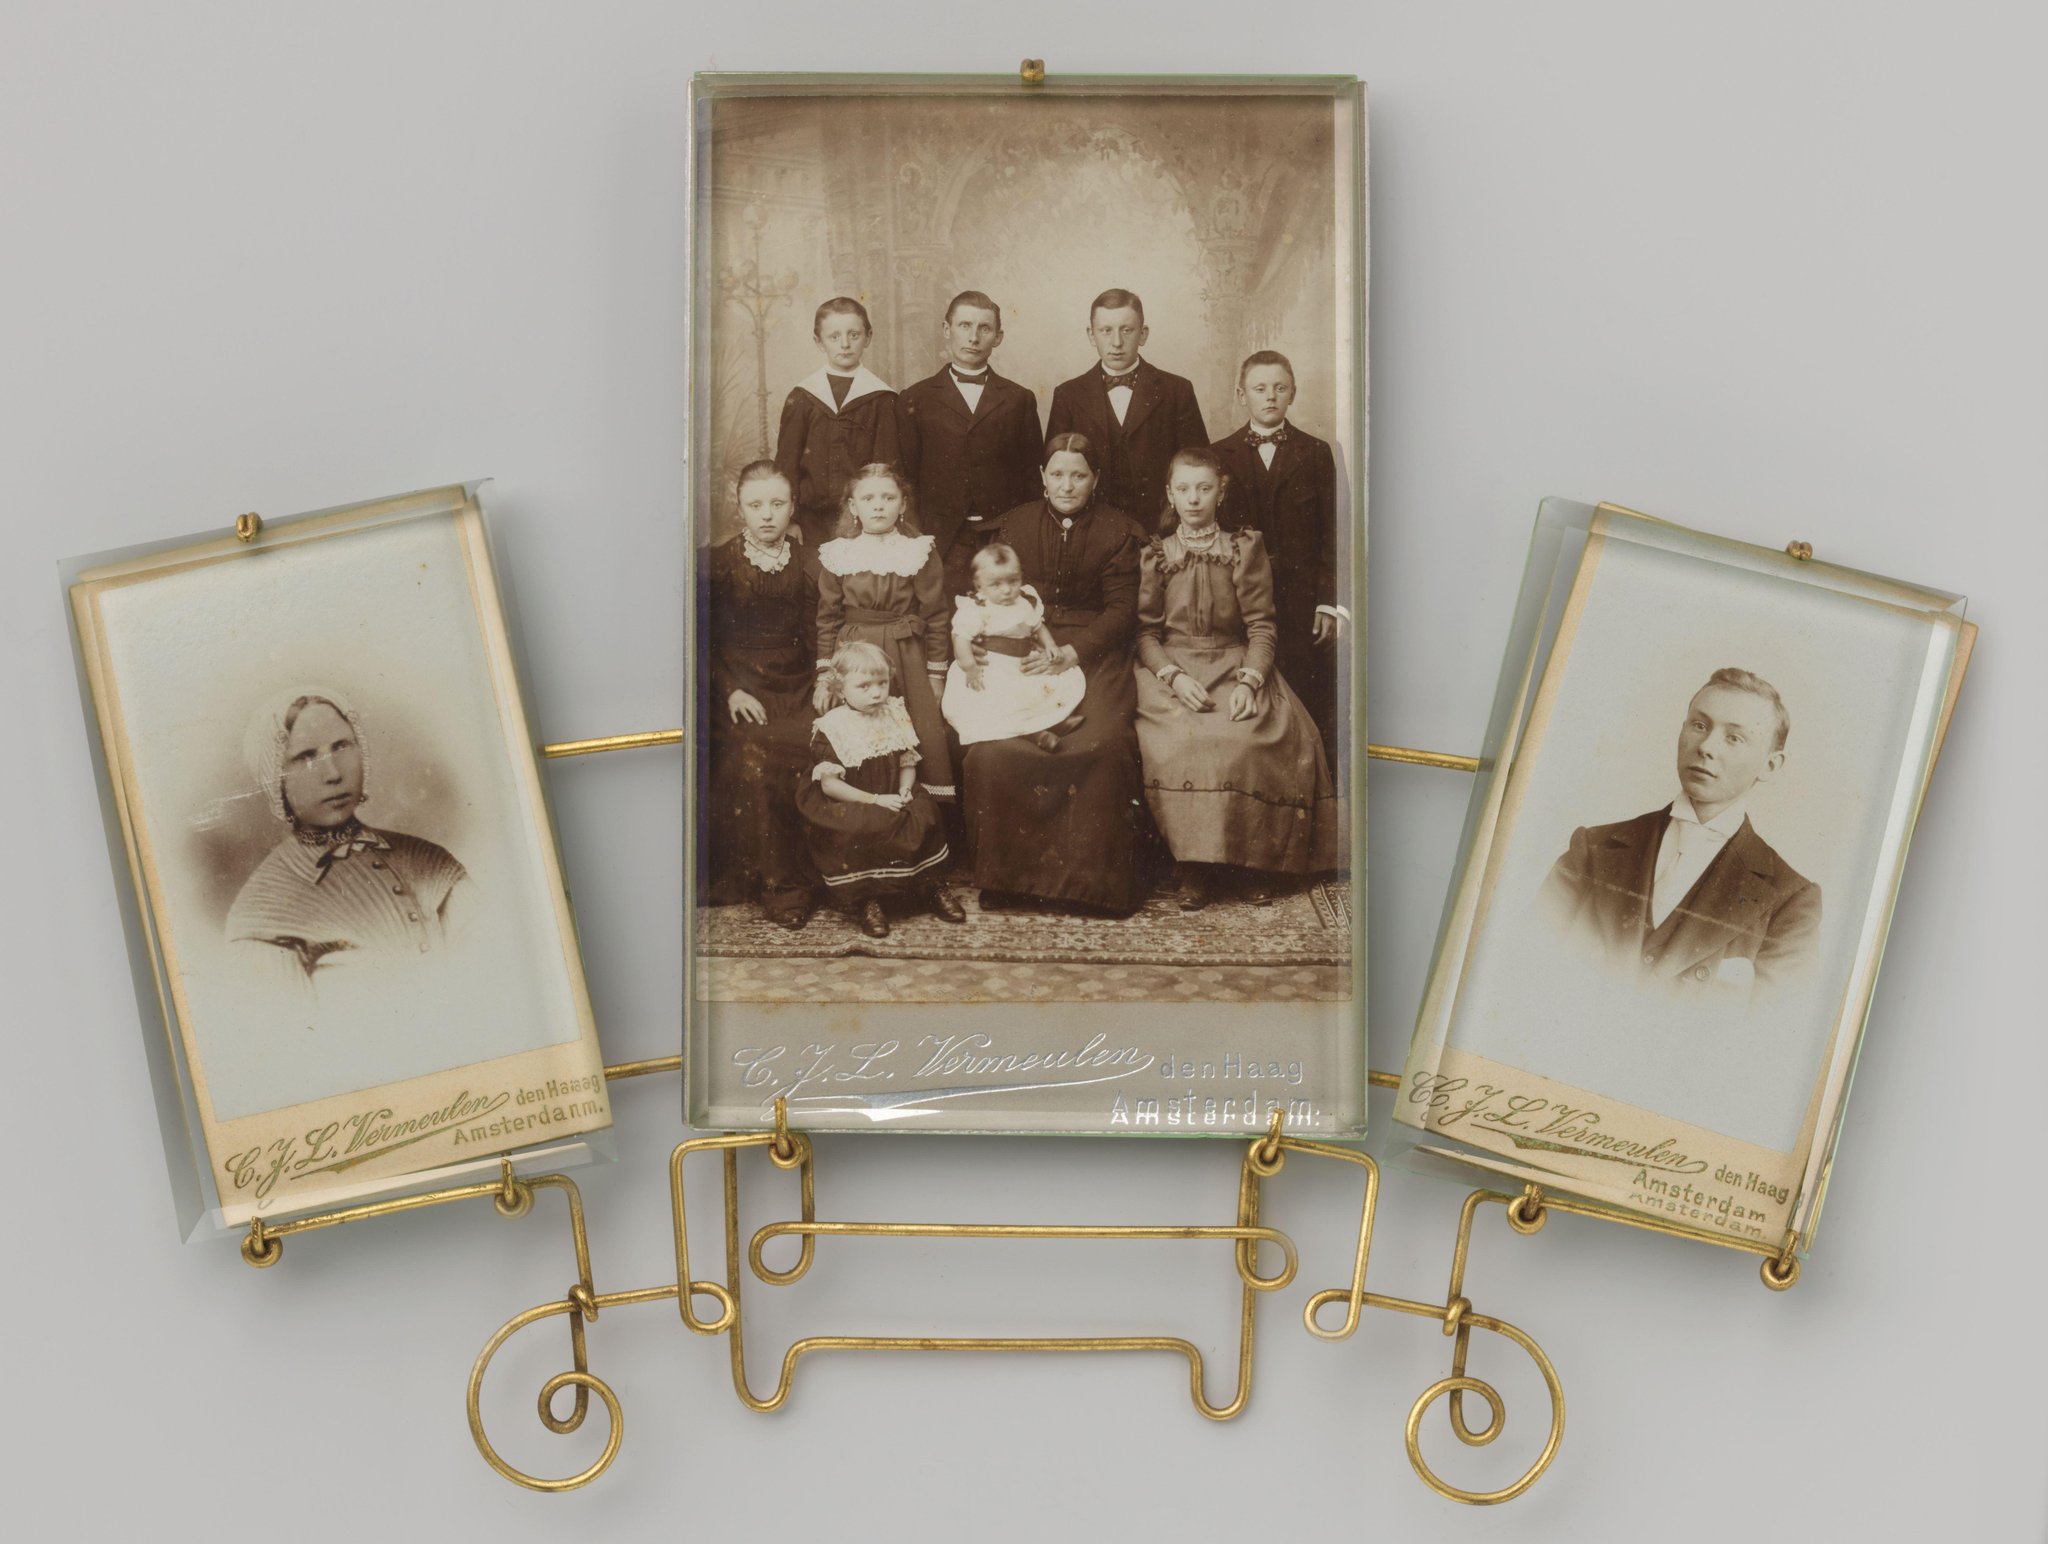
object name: carte de visite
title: Drie portretten van onbekende personen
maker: cornelis johannes lodewicus vermeulen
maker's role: fotograaf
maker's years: 1861-1936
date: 1880-1900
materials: paper, cardboard, glass, metal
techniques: collodion silver print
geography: amsterdam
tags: family group, especially parents with their child(ren), anonymous historical person portrayed, amsterdam